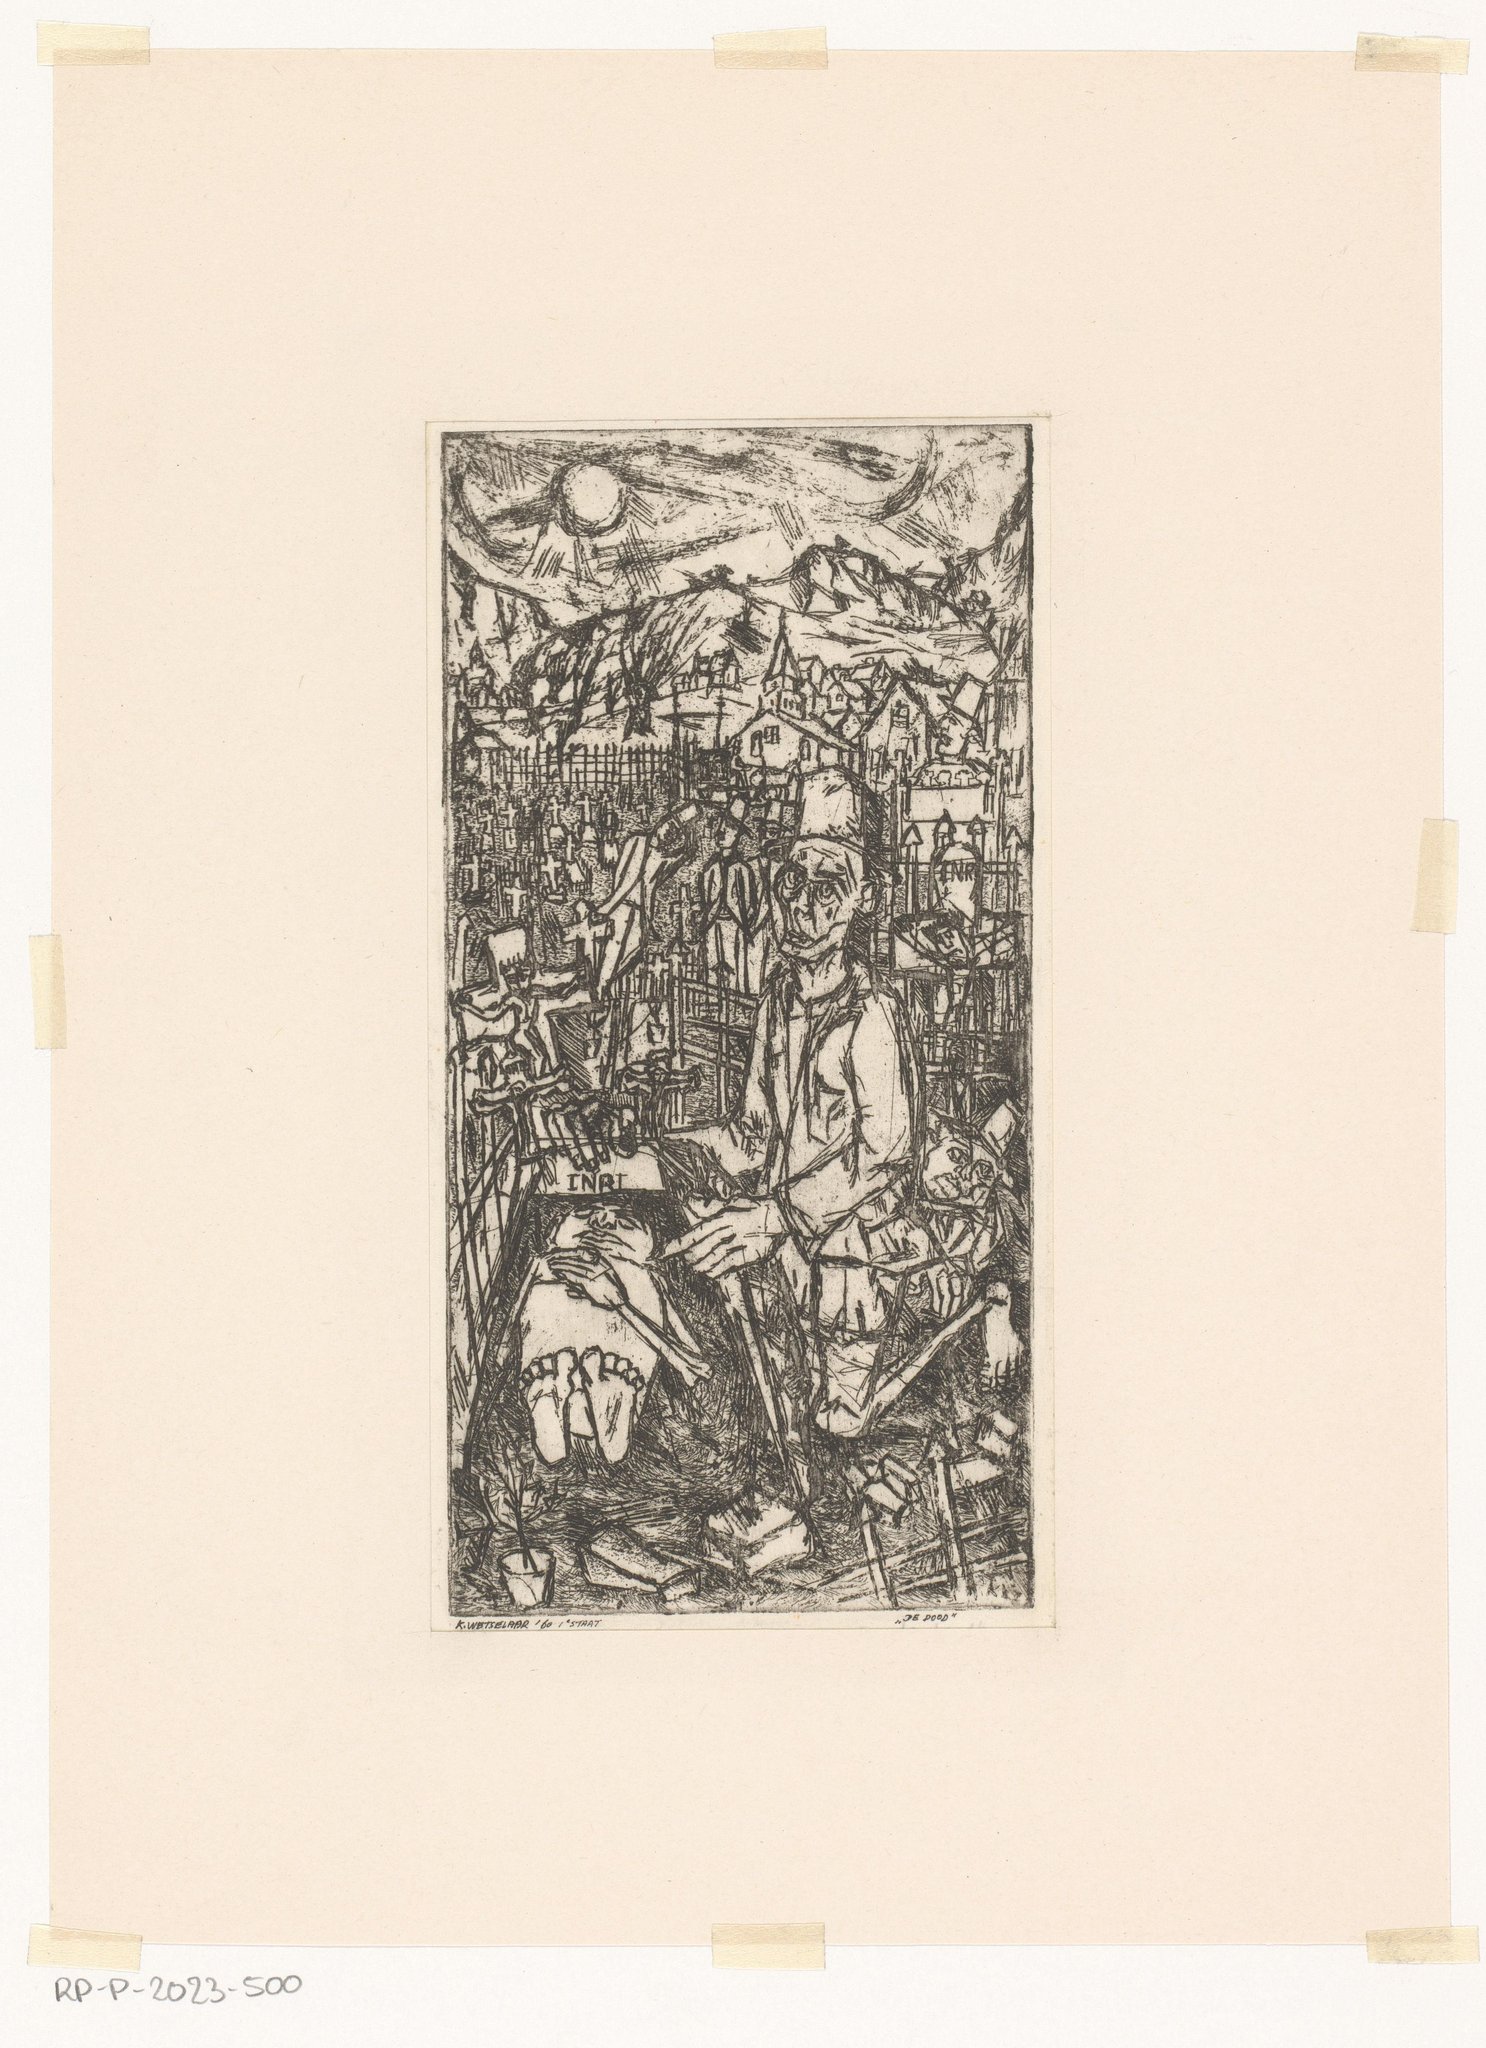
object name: print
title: De Dood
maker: karel wetselaar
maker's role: print maker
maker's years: 1935-2017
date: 1960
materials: paper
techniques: drypoint, etching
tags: churchyard, cemetery, grave, tomb and other grave-forms and grave-markers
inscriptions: inscription: ‘1e staat’, signature and date: ‘K. Wetselaar '60’